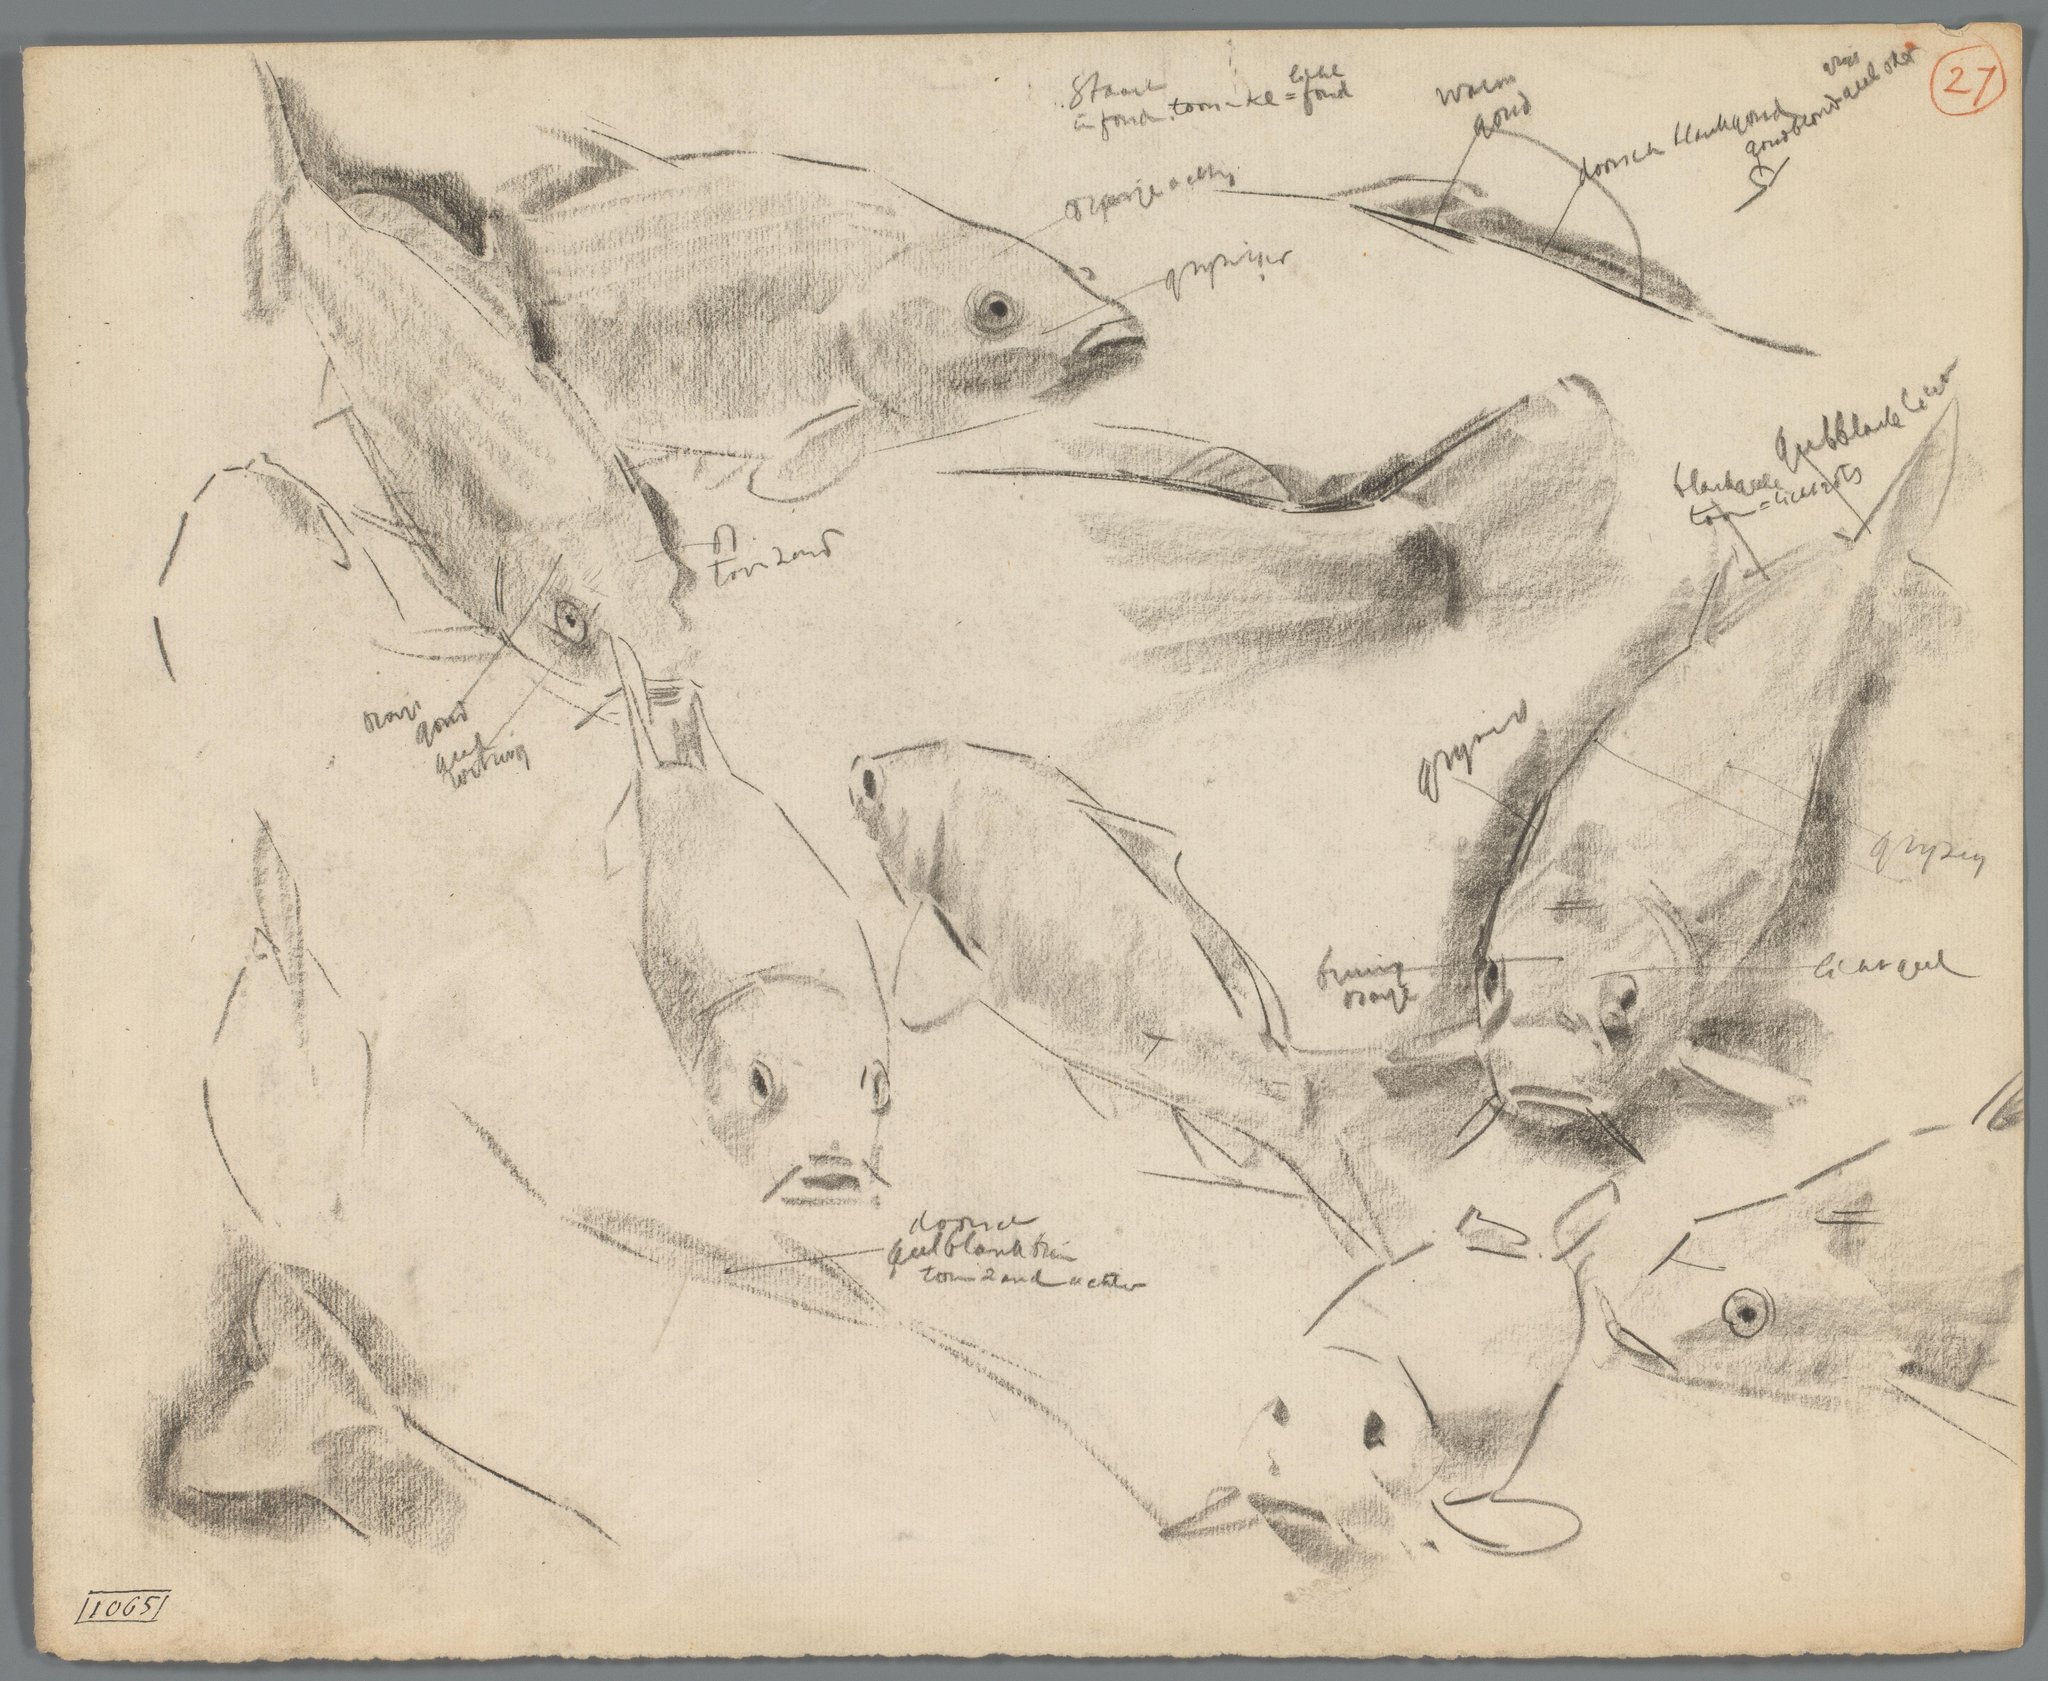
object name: drawing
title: Studies van karpers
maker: gerrit willem dijsselhof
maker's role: designer, draughtsman, print maker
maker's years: 1866-1924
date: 1876-1924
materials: chalk, paper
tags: bony fishes: carp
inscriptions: number: ‘1065’